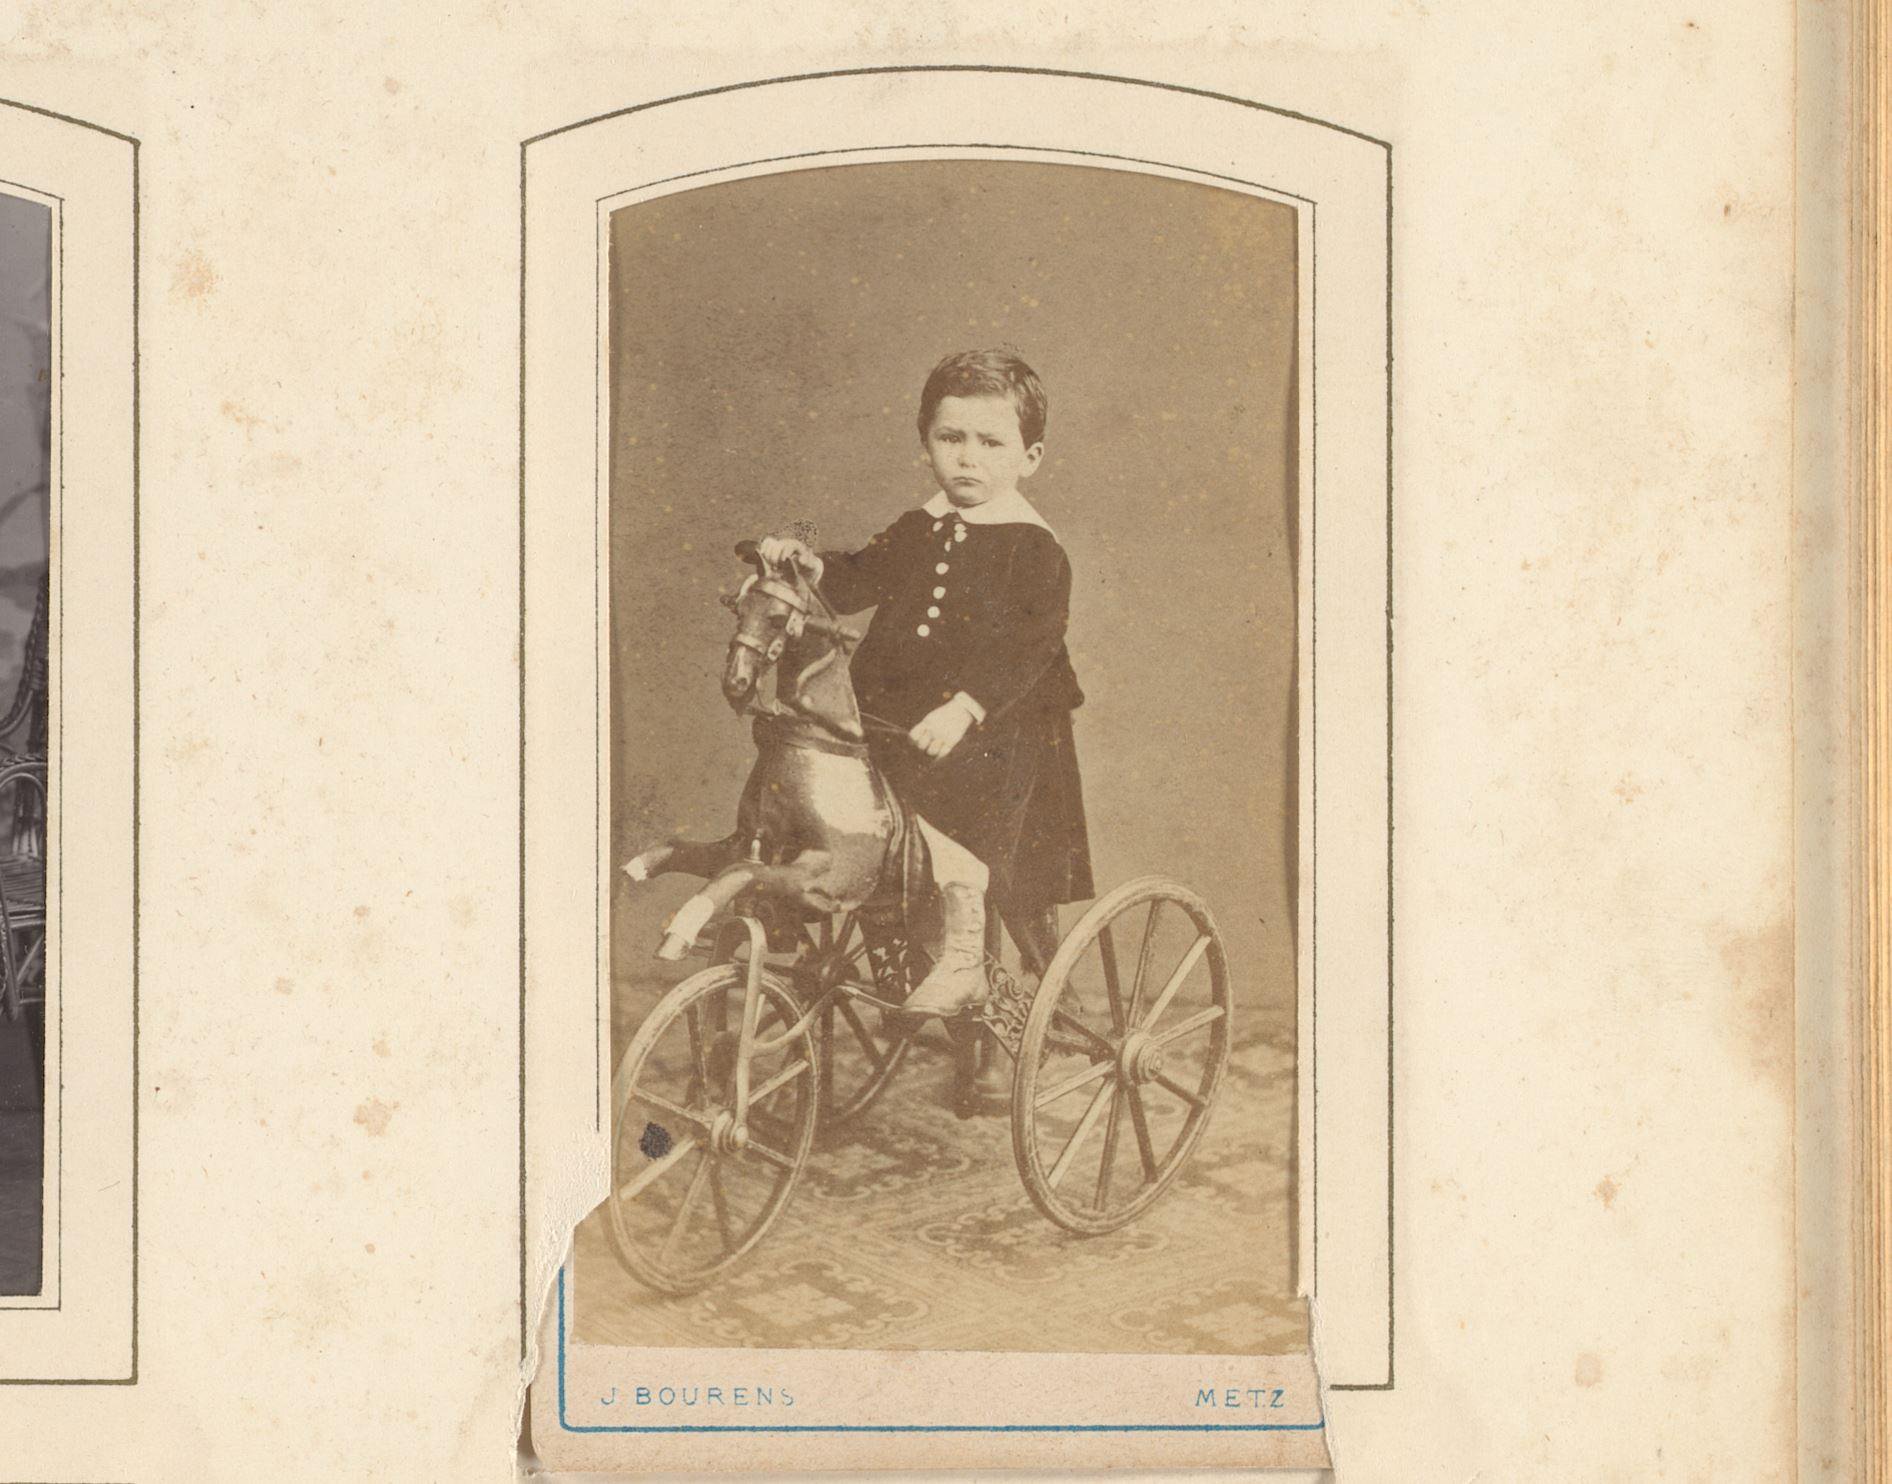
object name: photograph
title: Portret van een jongen op een speelgoed paard met wielen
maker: jean bourens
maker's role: fotograaf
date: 1860-1900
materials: cardboard, photographic support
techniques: albumen print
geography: metz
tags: boy (child between toddler and youth), historical persons, rocking-horse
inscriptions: inscription: ‘J. BOURENS/ Photographe/ Rue Serpenoise/ Nos 27 et 29/ METZ/ Les Clichés sont conservés pendant 3 ans’